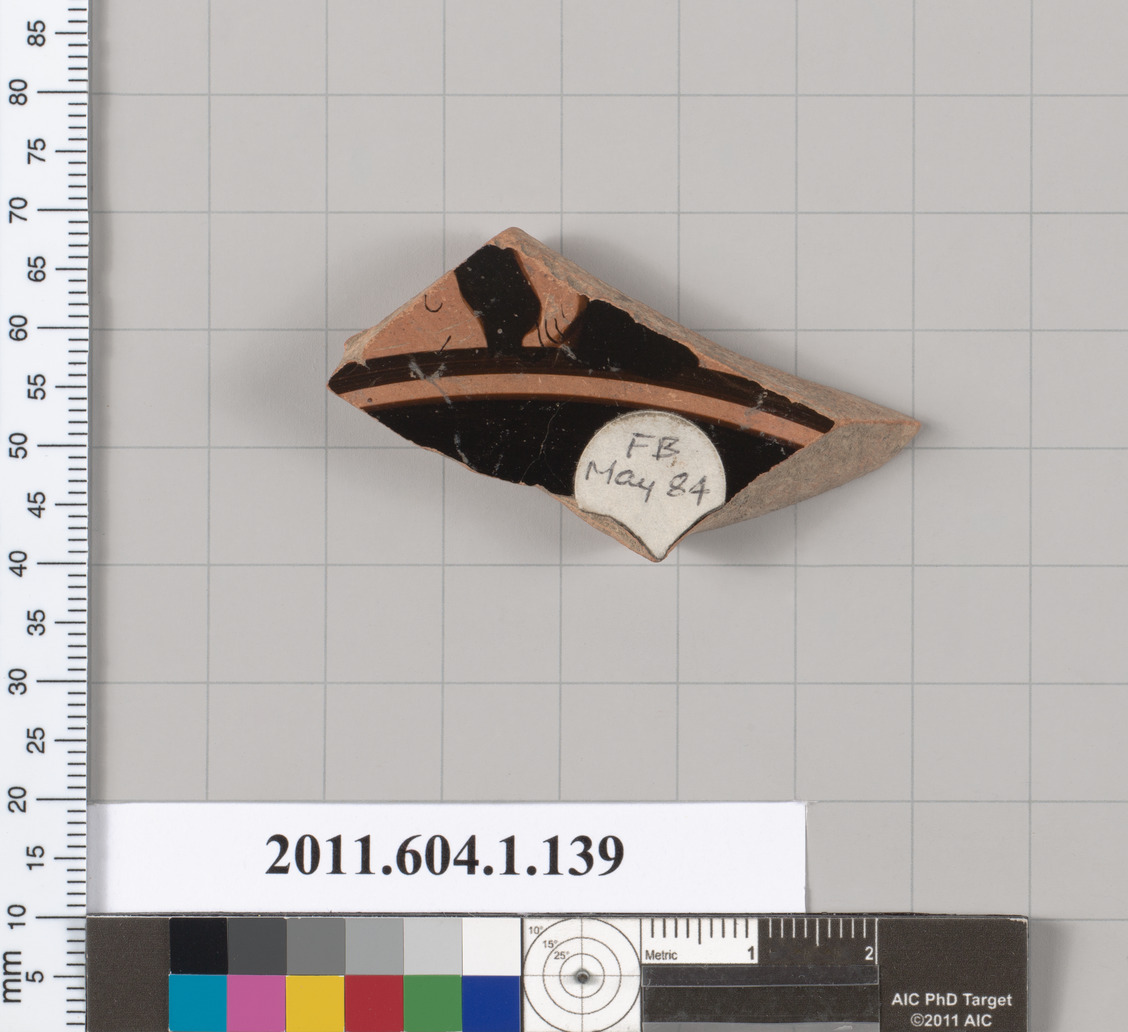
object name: kylix fragment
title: Terracotta fragment of a kylix (drinking cup)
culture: greek, attic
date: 475-451 BCE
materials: terracotta